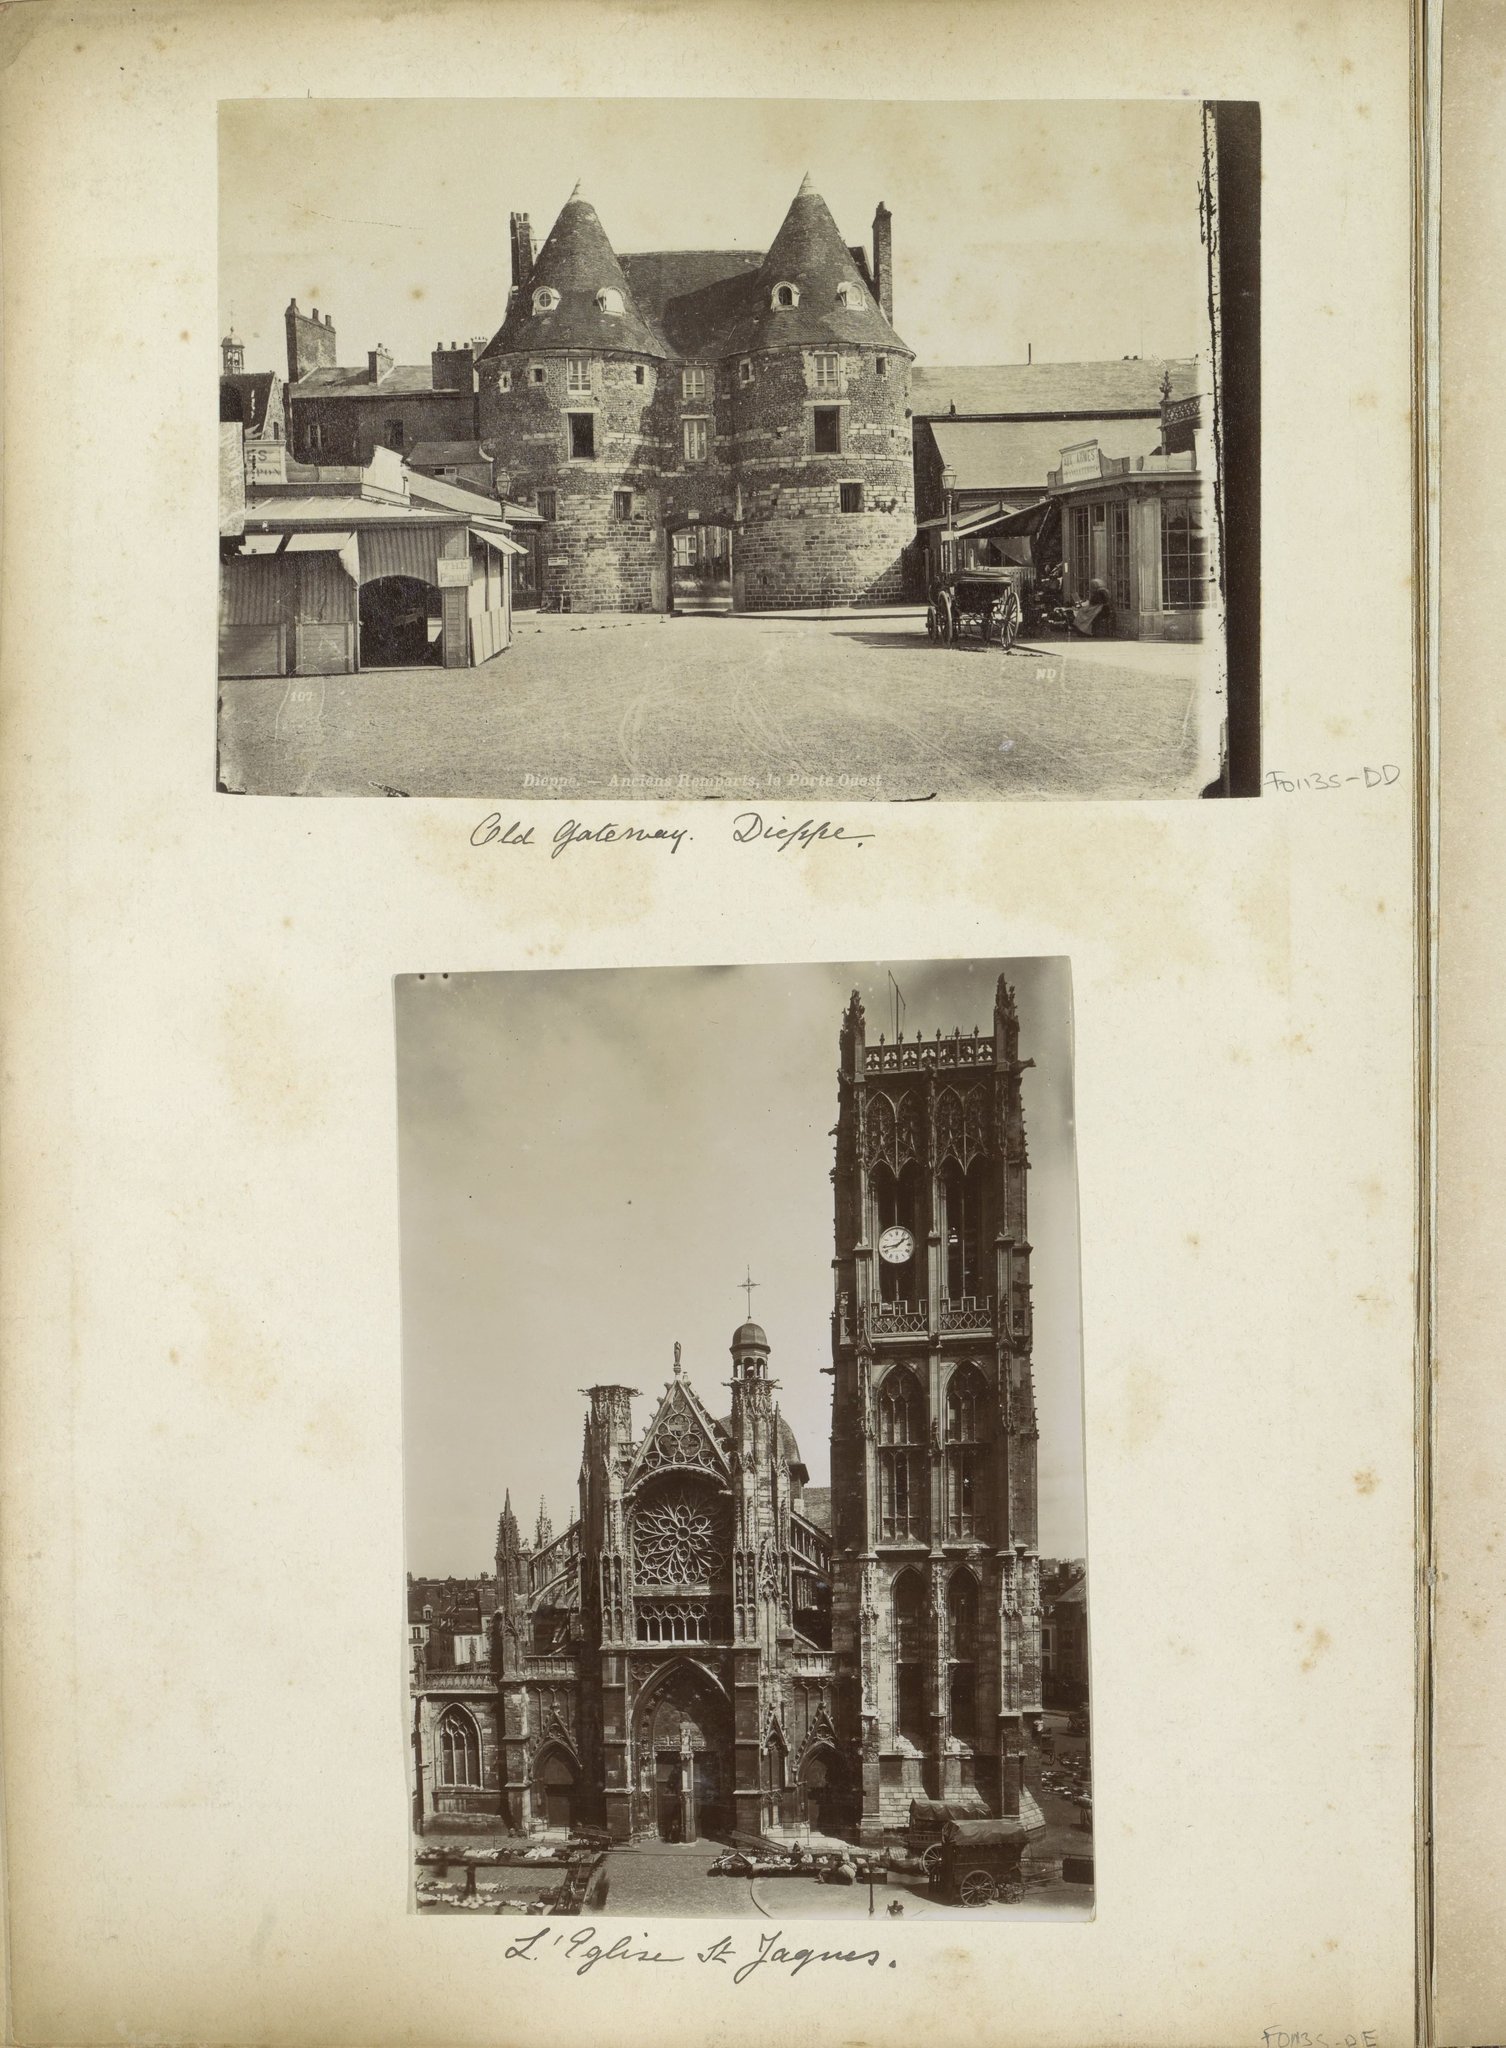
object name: album leaf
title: Dieppe. - Anciens Remparts, la Porte Ouest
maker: étienne neurdein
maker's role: publisher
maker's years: 1832-1918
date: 1901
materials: paper, photographic support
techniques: albumen print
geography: dieppe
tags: gate, entrance, city-walls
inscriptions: negative number: ‘107’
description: Onderdeel van Reisalbum met foto's van bezienswaardigheden in Engeland en Frankrijk.